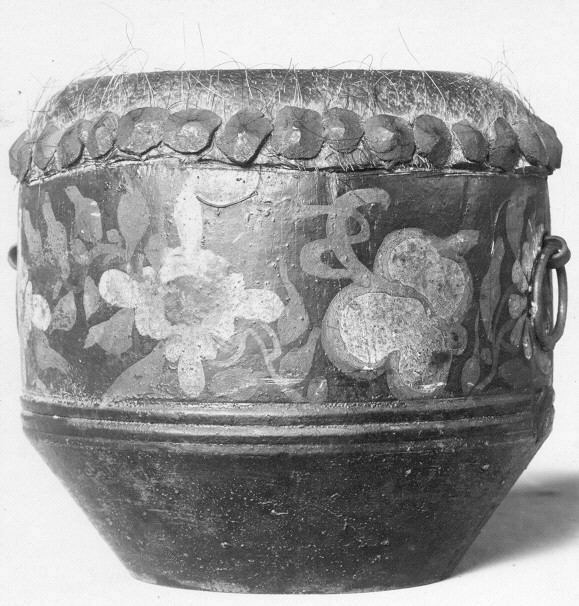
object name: gu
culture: chinese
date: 1801-1900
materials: leather, wood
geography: china